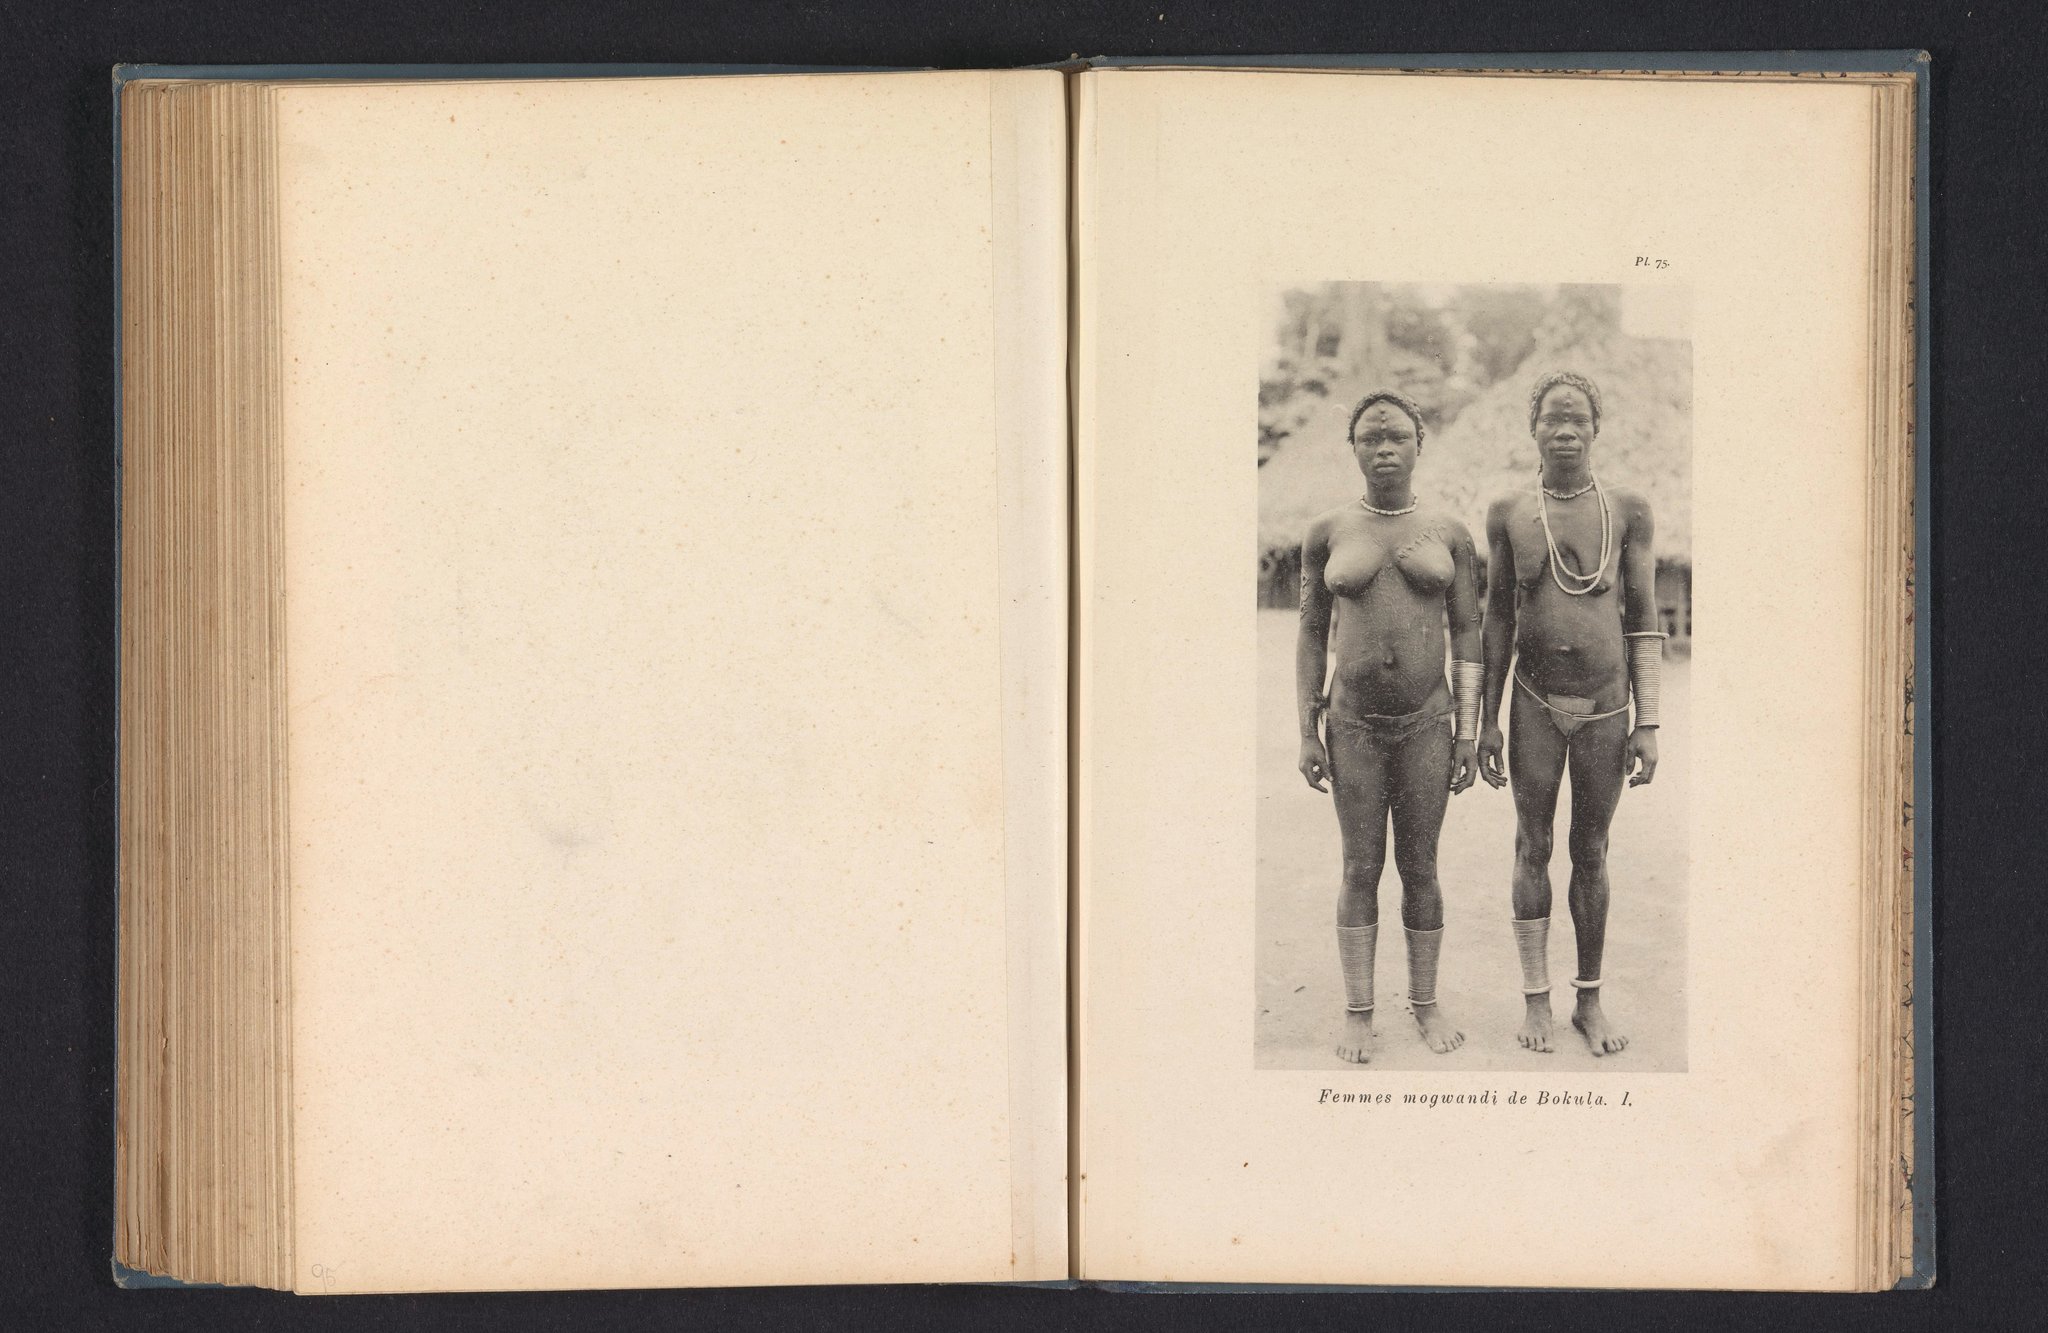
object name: page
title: Portret van twee vrouwen van de Ngbandi te Bokula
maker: franz thonner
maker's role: botanicus, ontdekkingsreiziger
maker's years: 1863-1928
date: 1896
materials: paper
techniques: photograph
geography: dresden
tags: adult woman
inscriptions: number: ‘Pl. 75.’